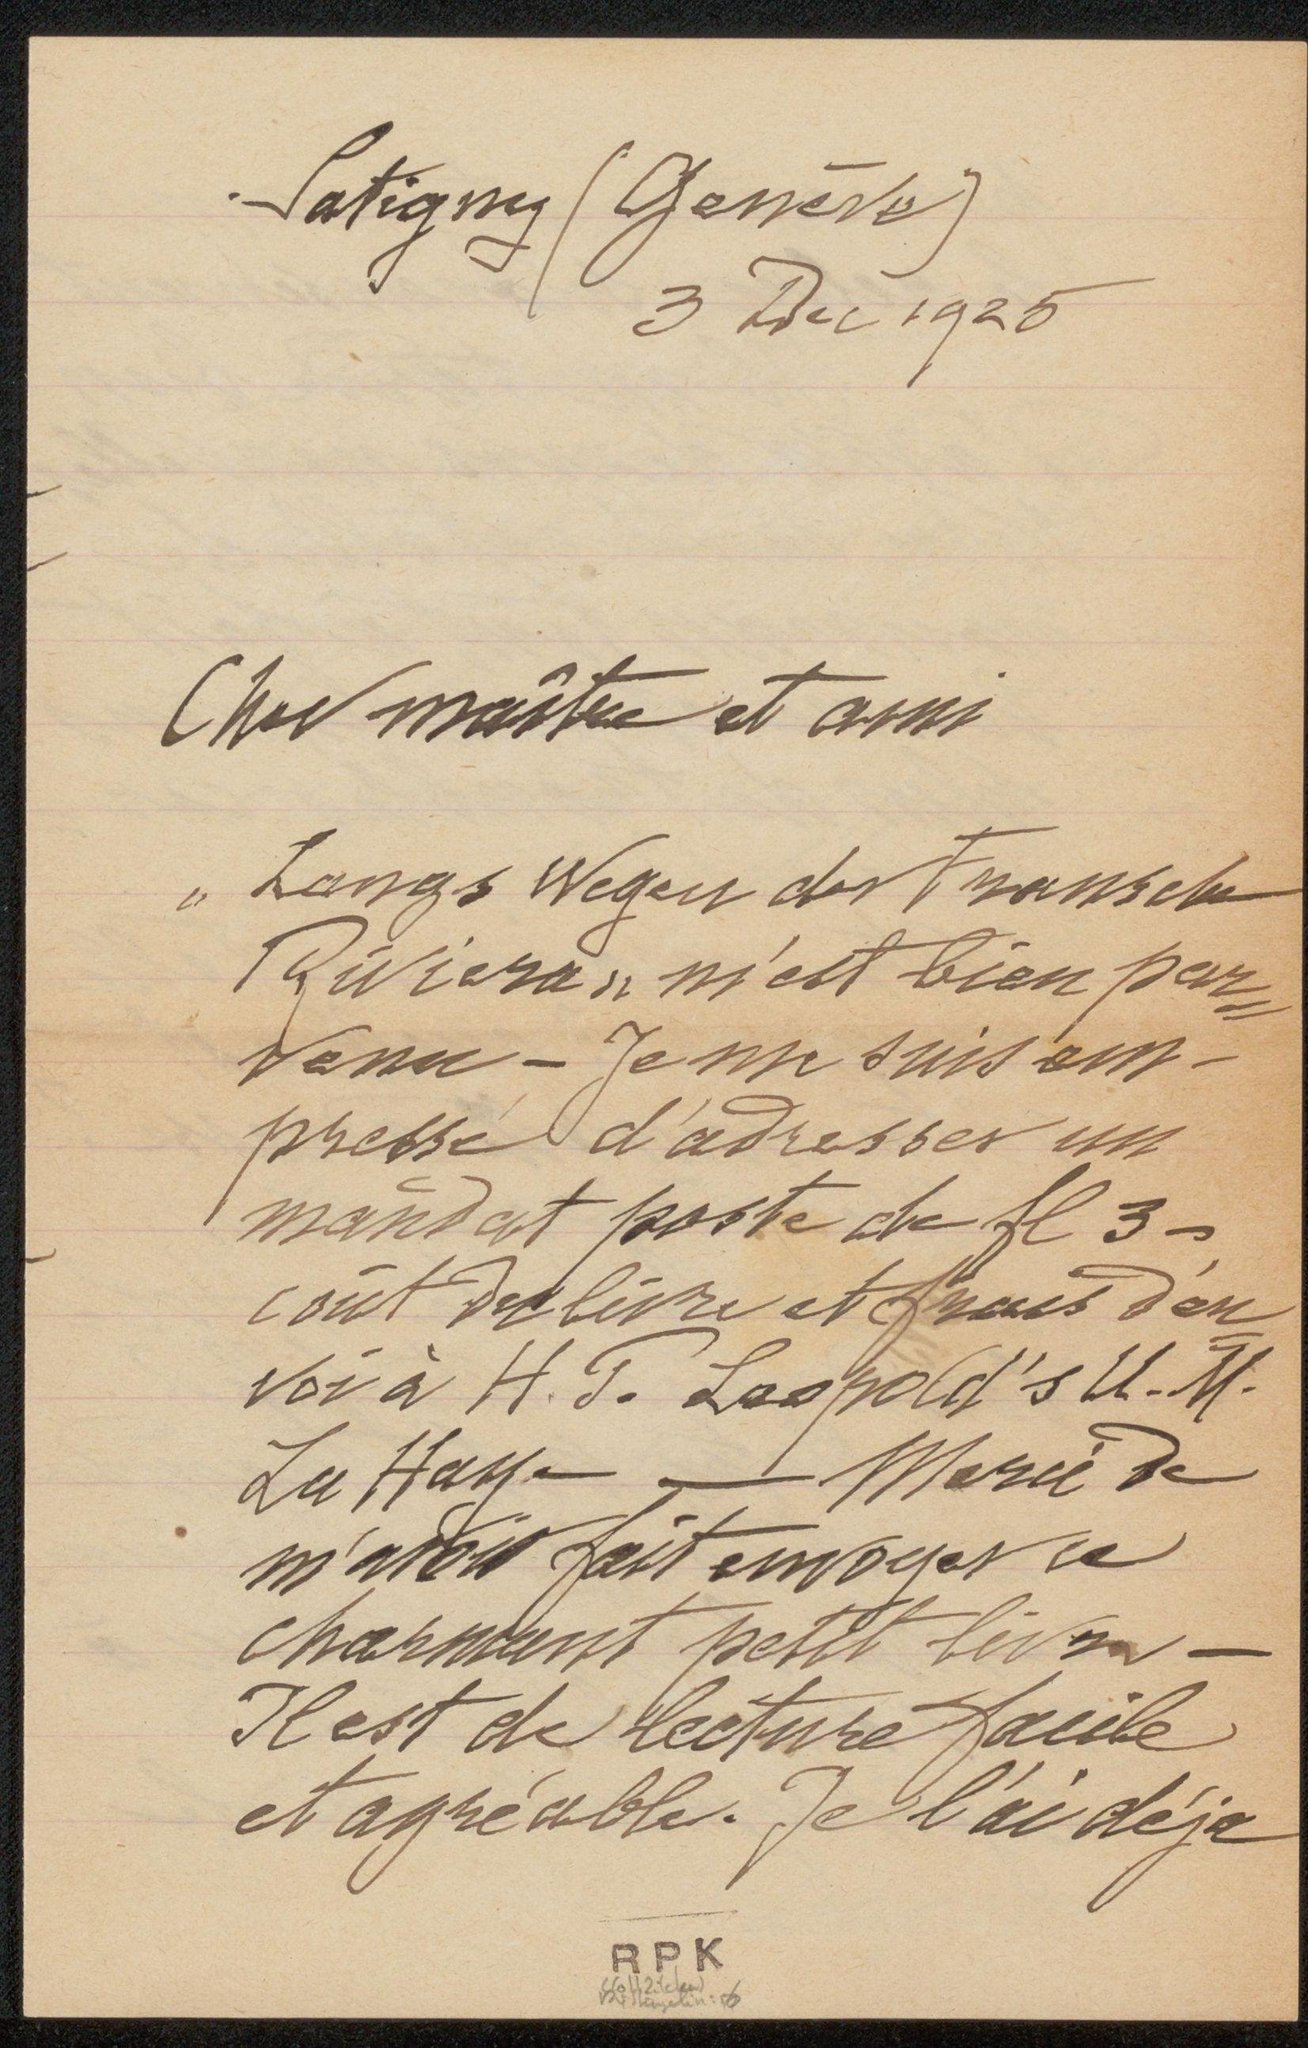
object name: letter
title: Brief aan Philip Zilcken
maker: alphonse stengelin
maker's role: painter, print maker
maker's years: 1852-1938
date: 1925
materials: ink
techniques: pen, writing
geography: satigny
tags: lyon, paris, print maker, draughtsman, pierre cécile puvis de chavannes, publisher, philip zilcken, sculpture, exhibition ~ art, money, printed matter, netherlands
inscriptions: collector's mark: ‘RPK’